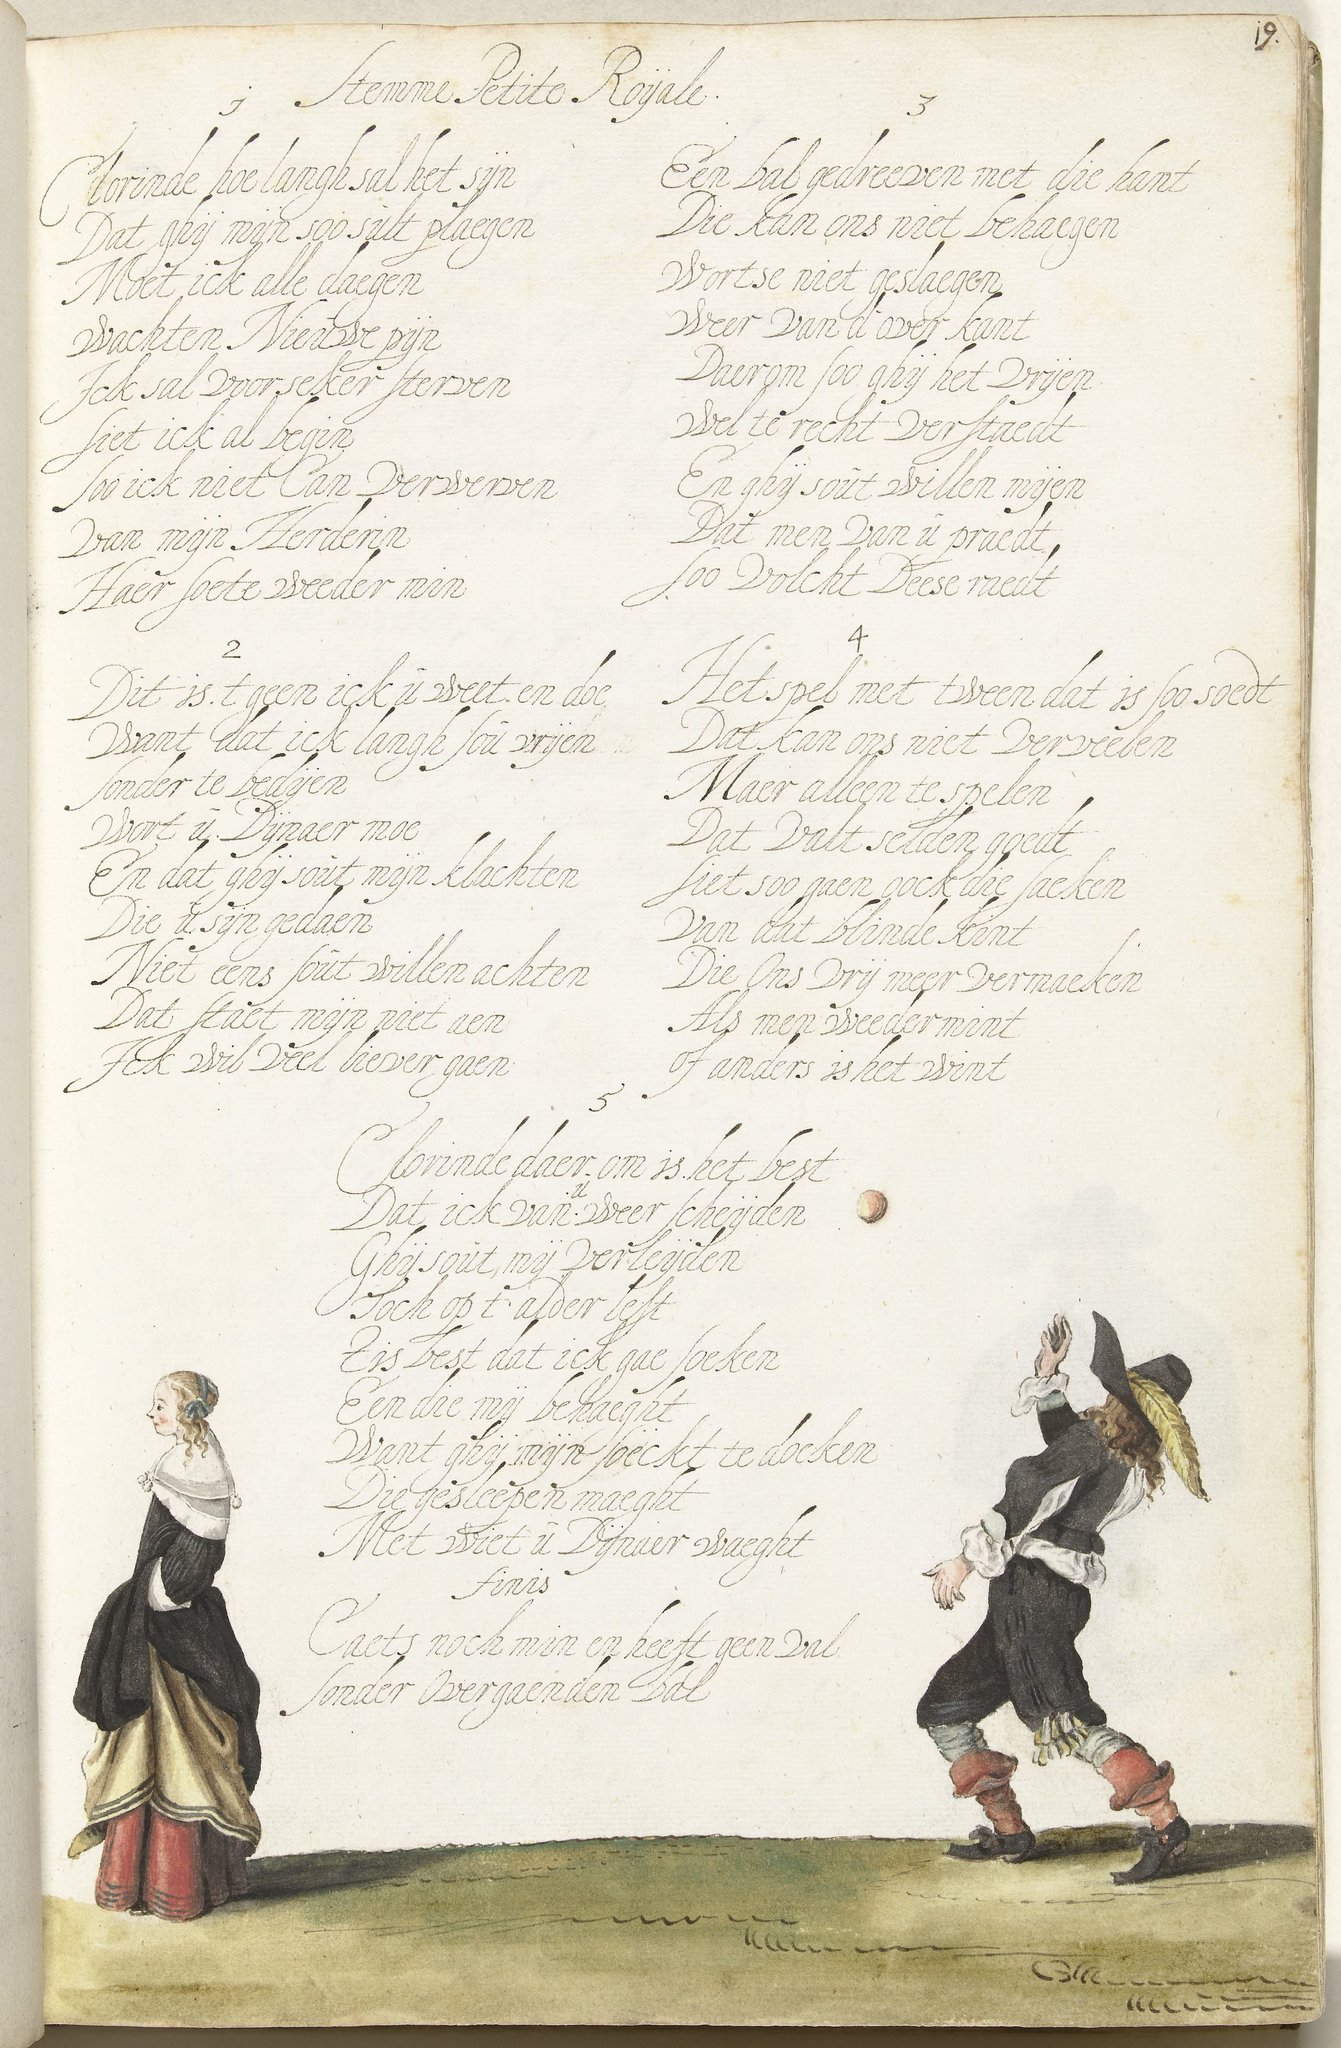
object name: watercolor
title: Heer die een bal gooit en een dame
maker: gesina ter borch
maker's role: draughtsman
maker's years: 1633-1690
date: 1652-1653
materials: ink, paper, watercolor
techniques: brush, calligraphy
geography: zwolle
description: Heer die een bal gooit en een dame die hem de rug toekeert. Het gooien van de bal die niet teruggegooid wordt is een metafoor voor zijn onbeantwoorde liefde. Liefdesklacht van vijf coupletten van negen regels, op de wijs van Petite Roijale.